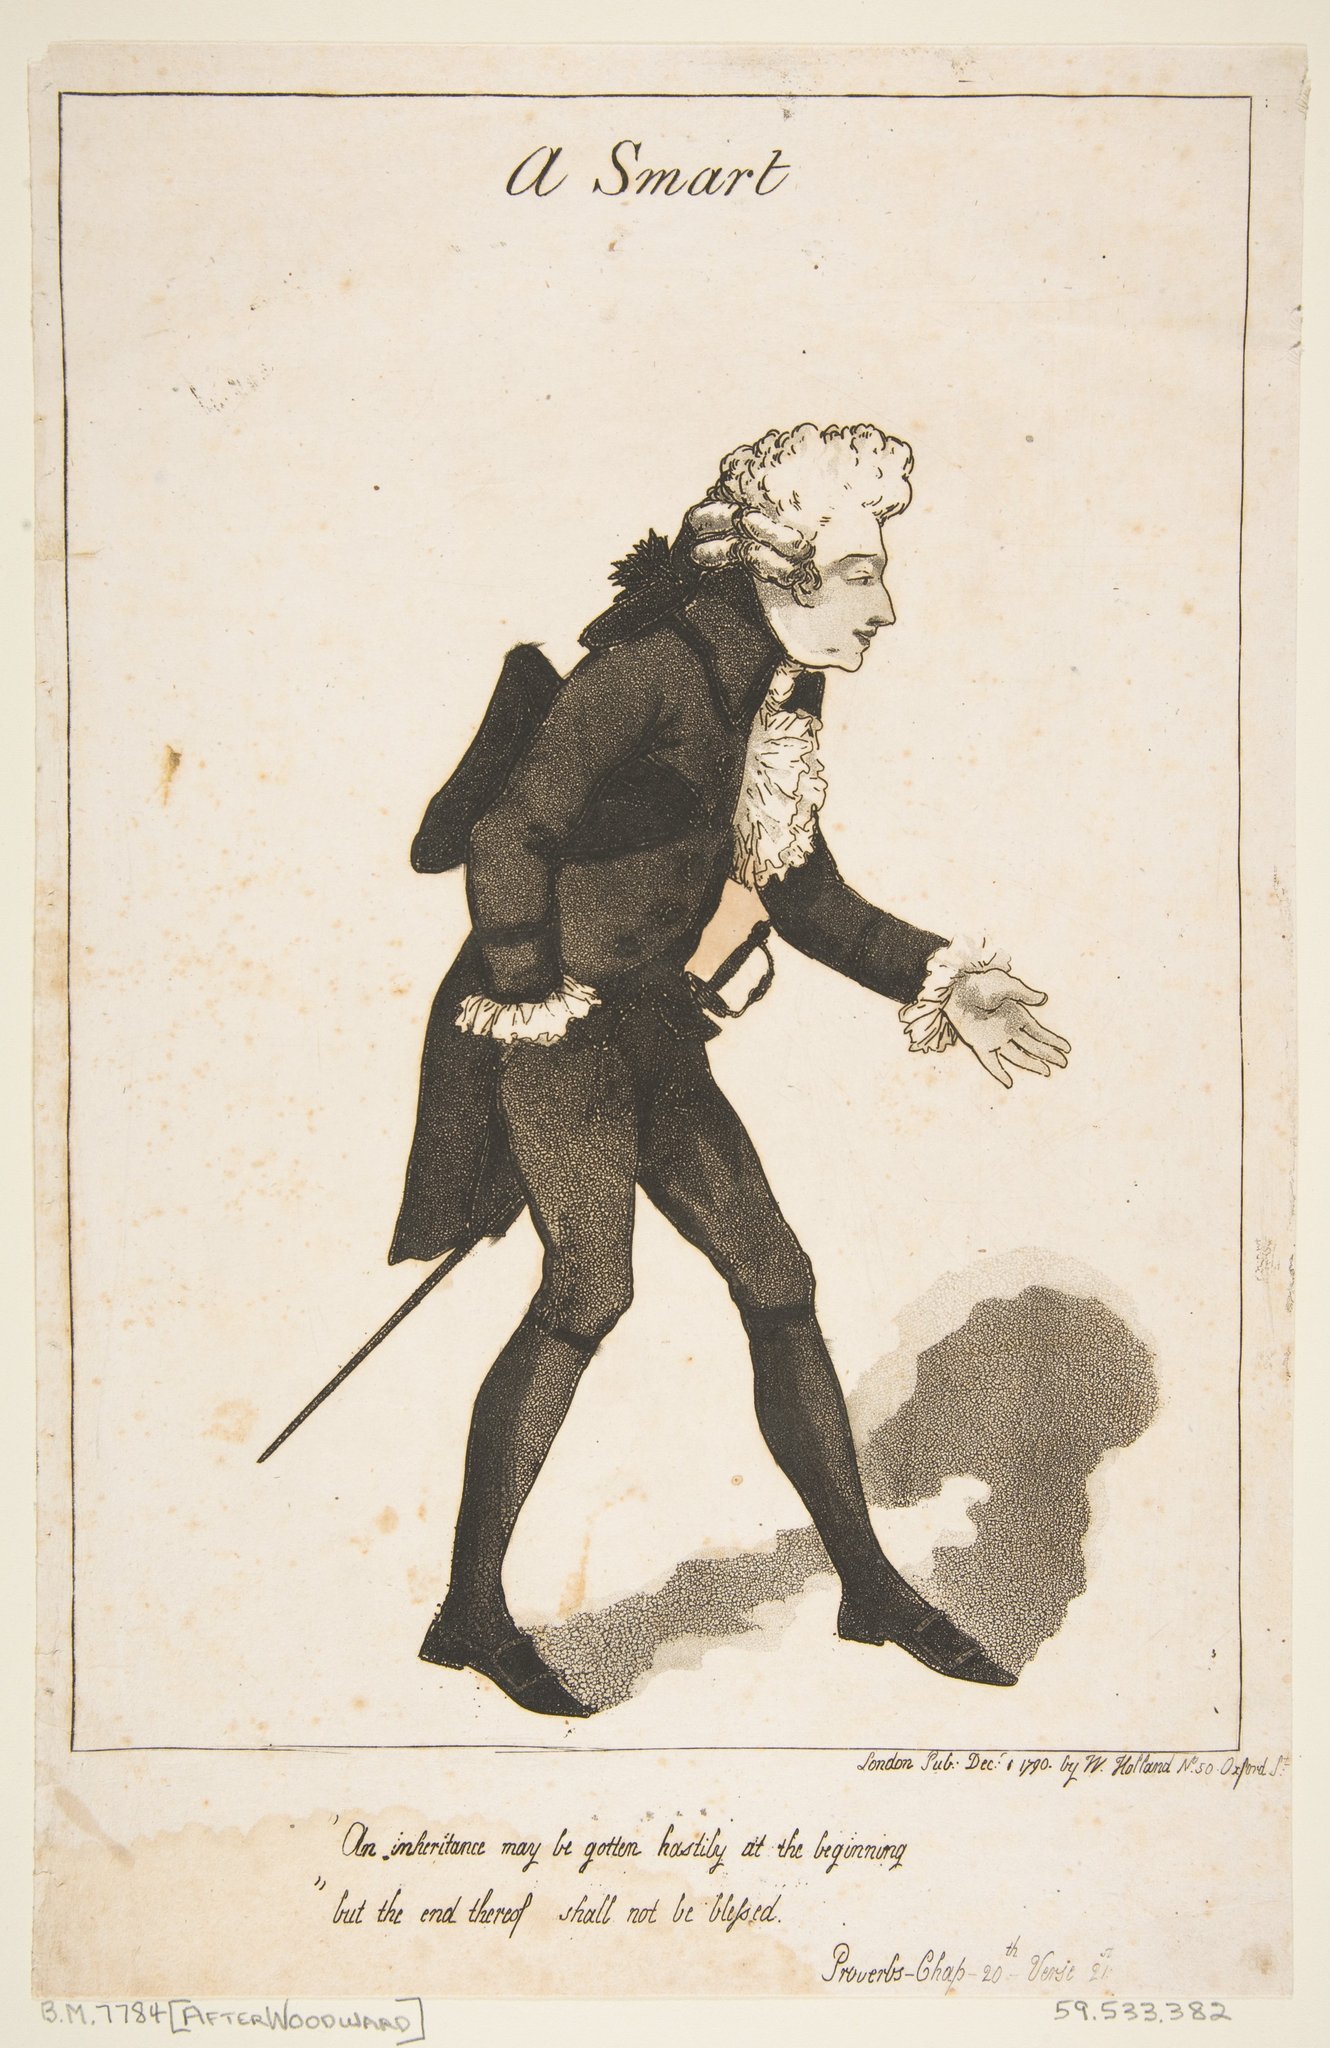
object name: print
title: A Smart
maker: thomas rowlandson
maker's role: artist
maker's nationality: british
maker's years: 1757-1827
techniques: aquatint, etching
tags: satire,men